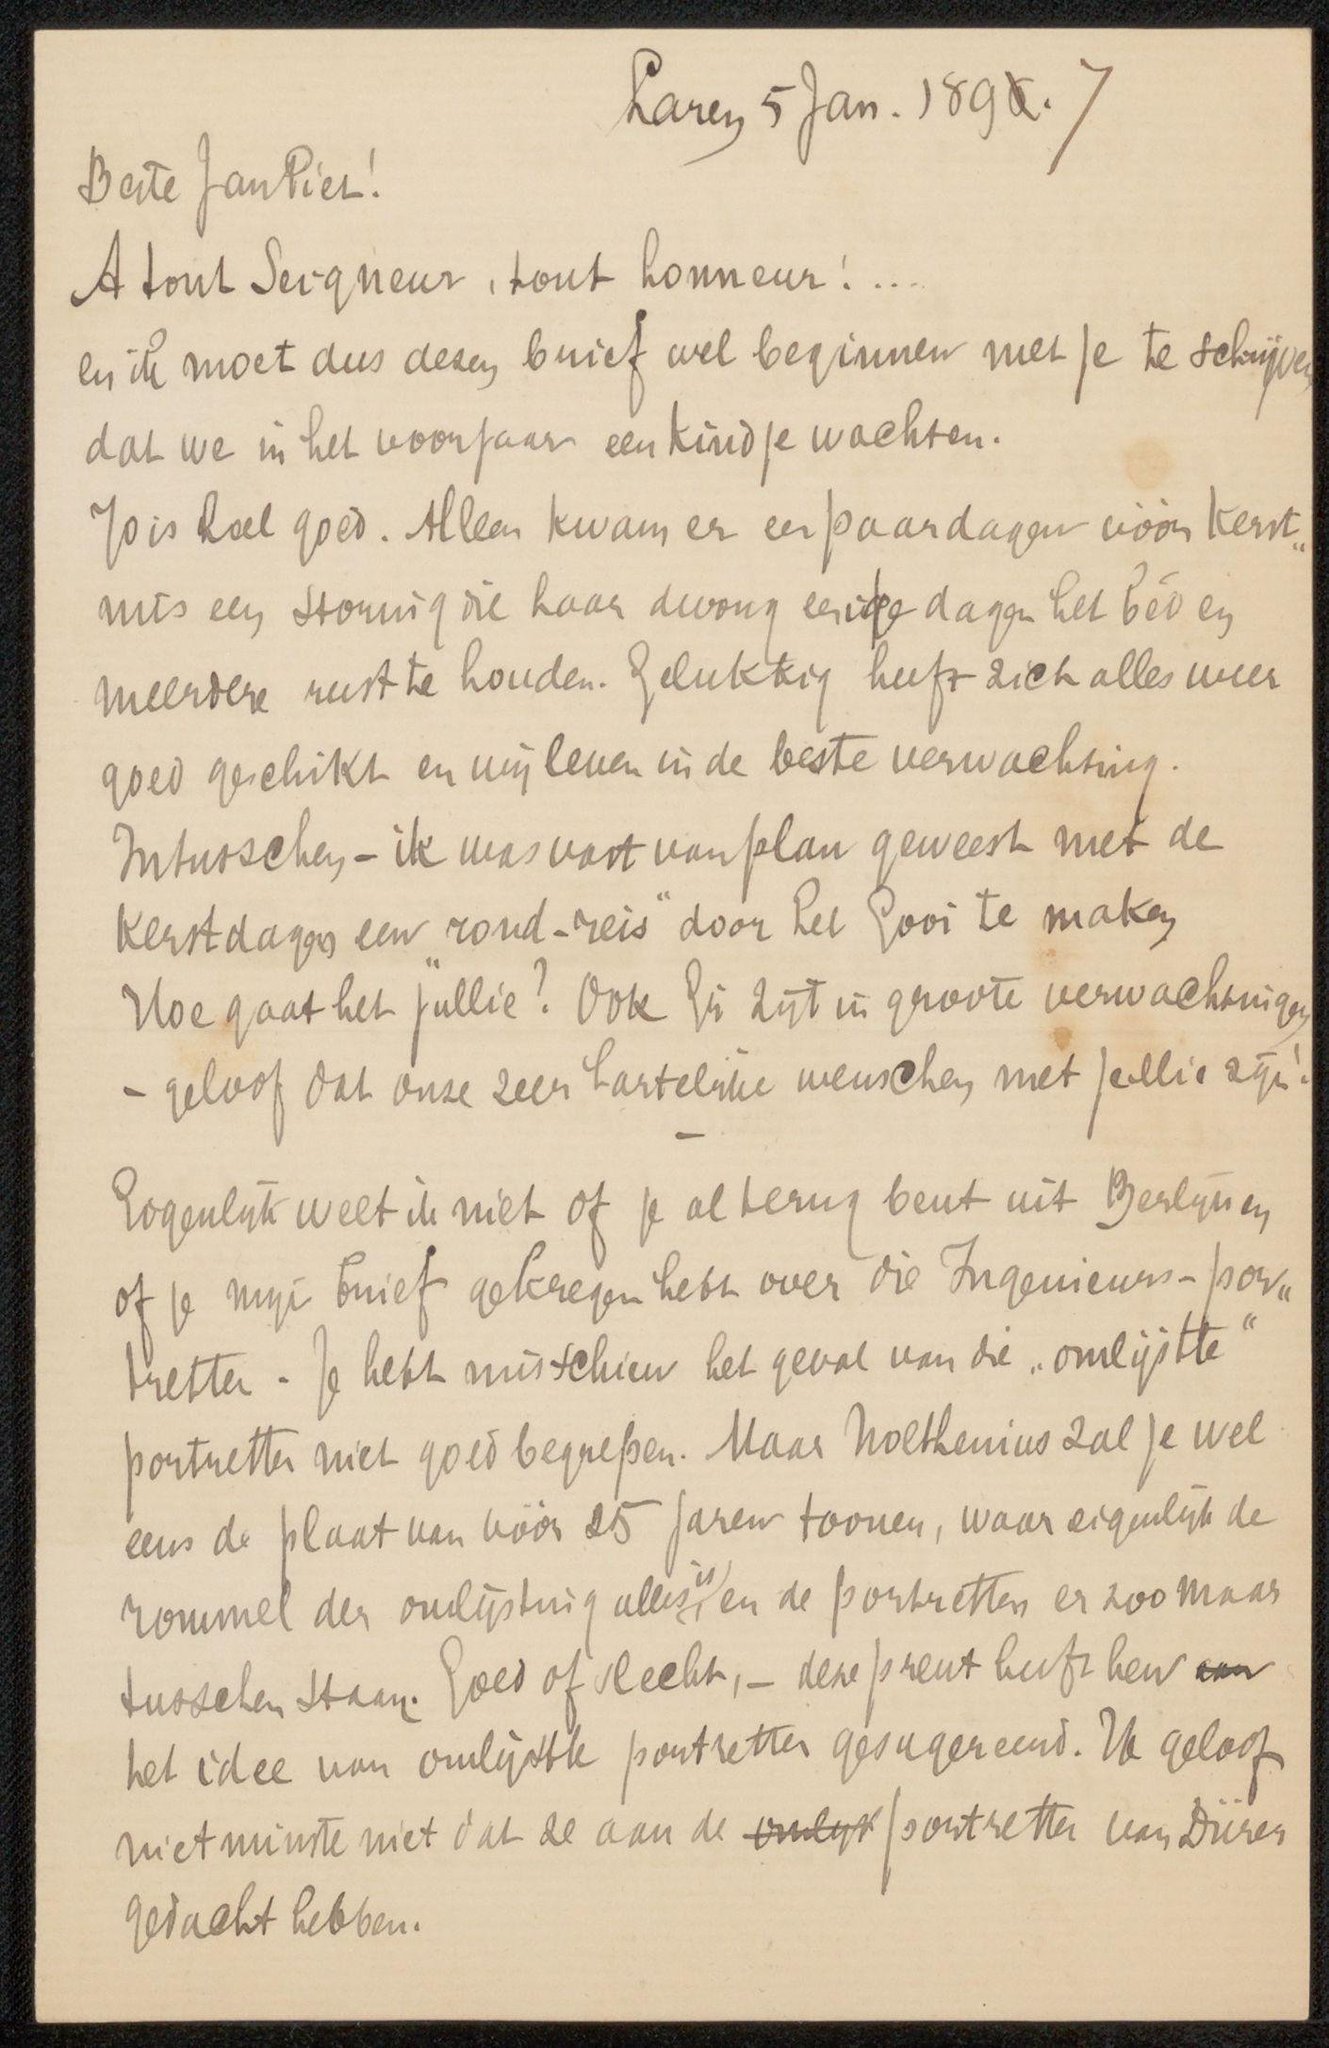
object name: letter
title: Brief aan Jan Veth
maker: antoon derkinderen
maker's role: draughtsman, painter, print maker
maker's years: 1859-1925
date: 1897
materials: ink, paper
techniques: pen, writing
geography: laren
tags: dordrecht, designer, jan veth, theo molkenboer, pieter lodewijk tak, family life, anonymous historical person portrayed, printed matter, berlin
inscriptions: collector's mark: ‘RPK’